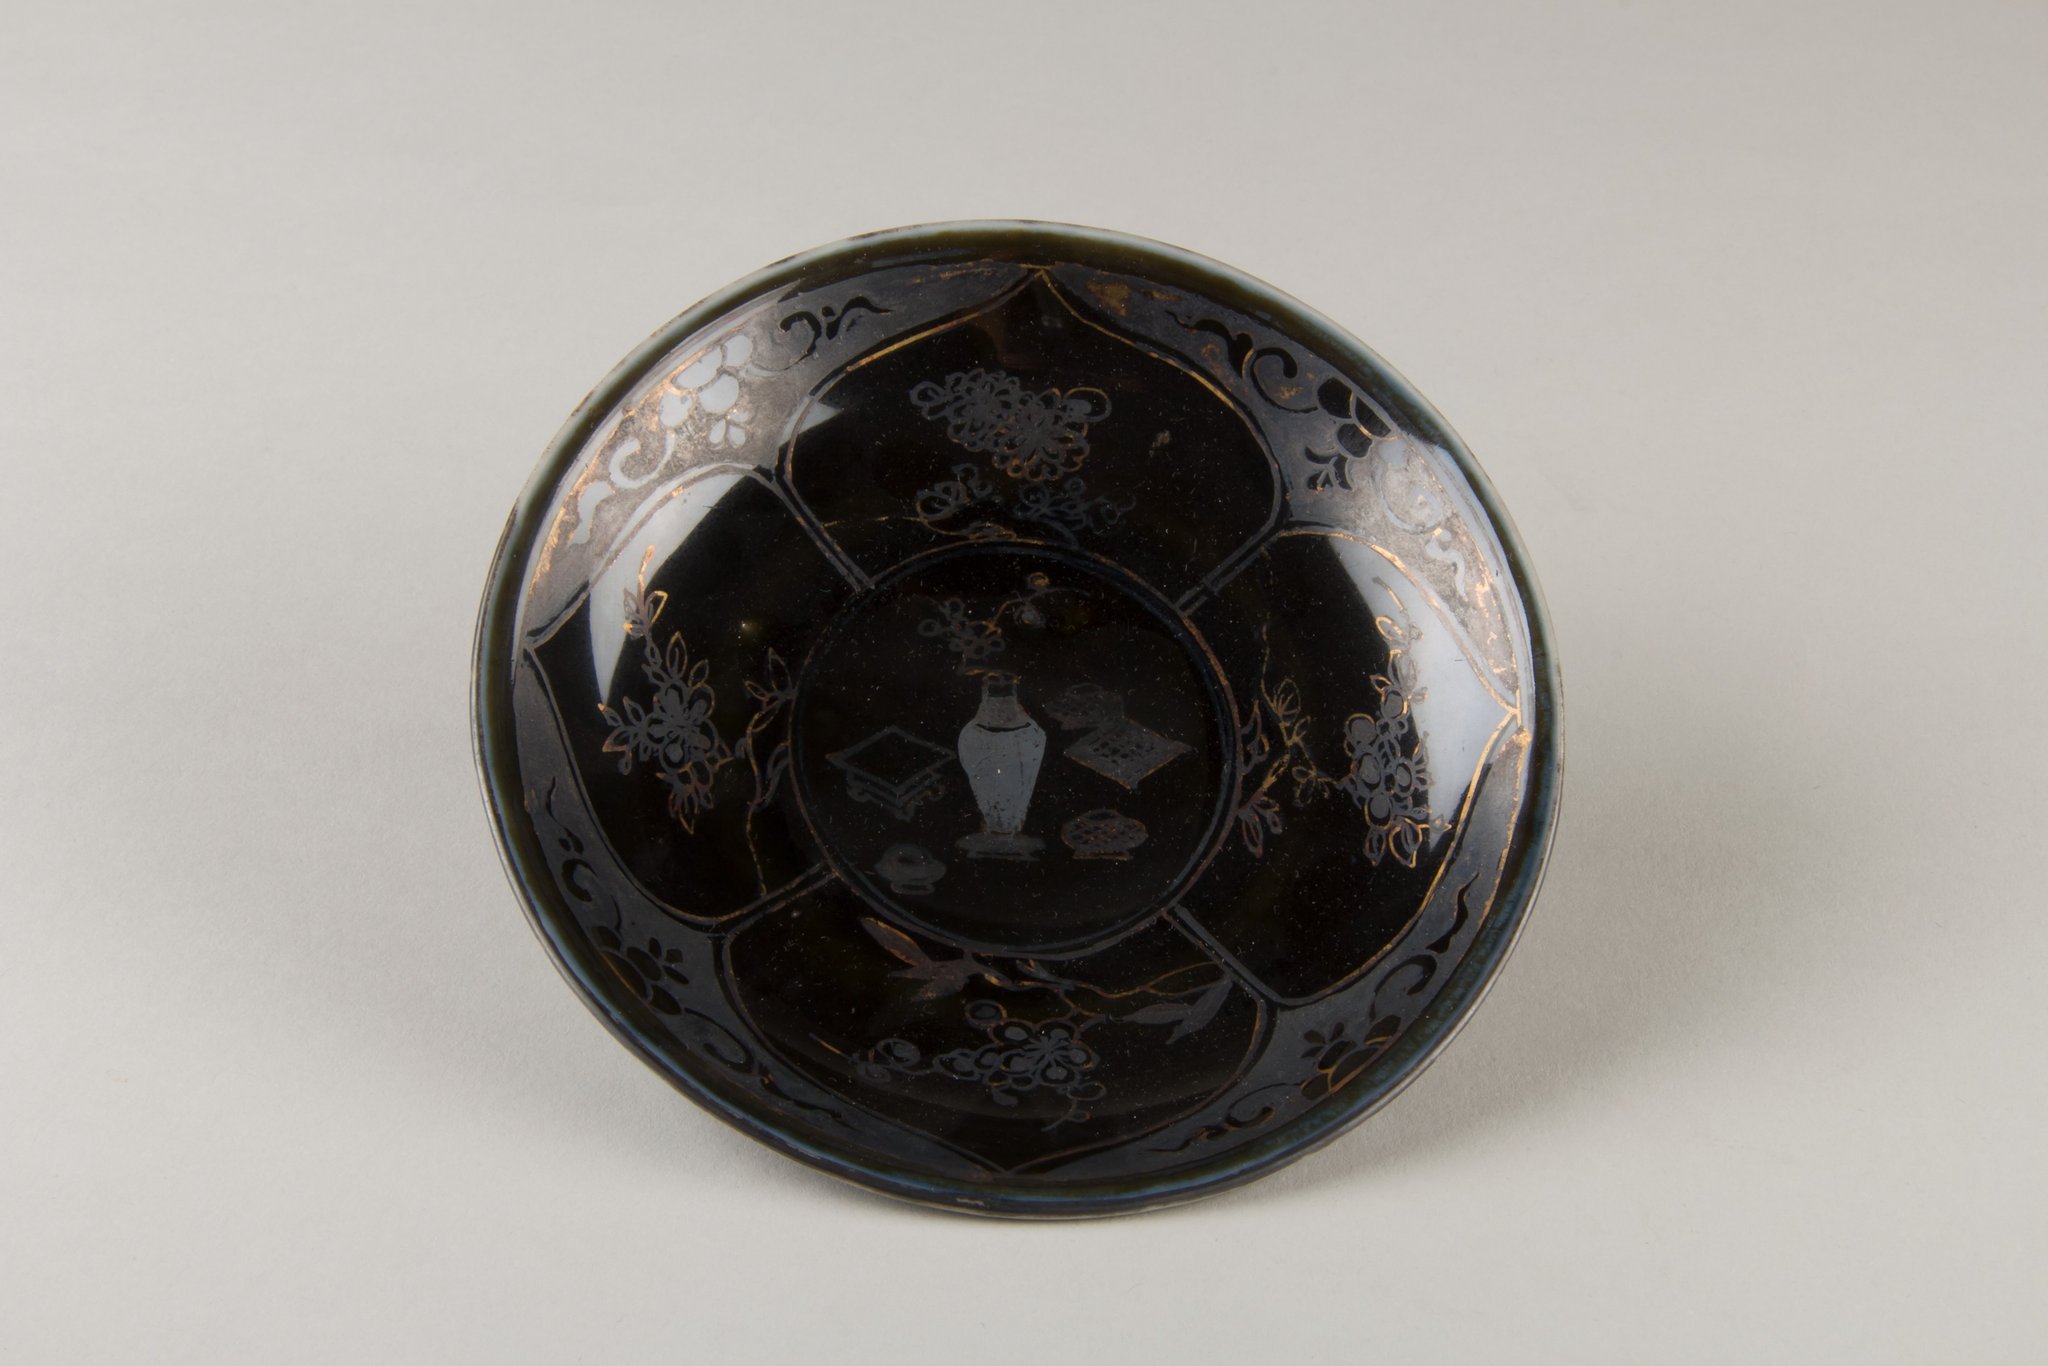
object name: saucer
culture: chinese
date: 1736-1795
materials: gilt, glaze, porcelain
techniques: painting